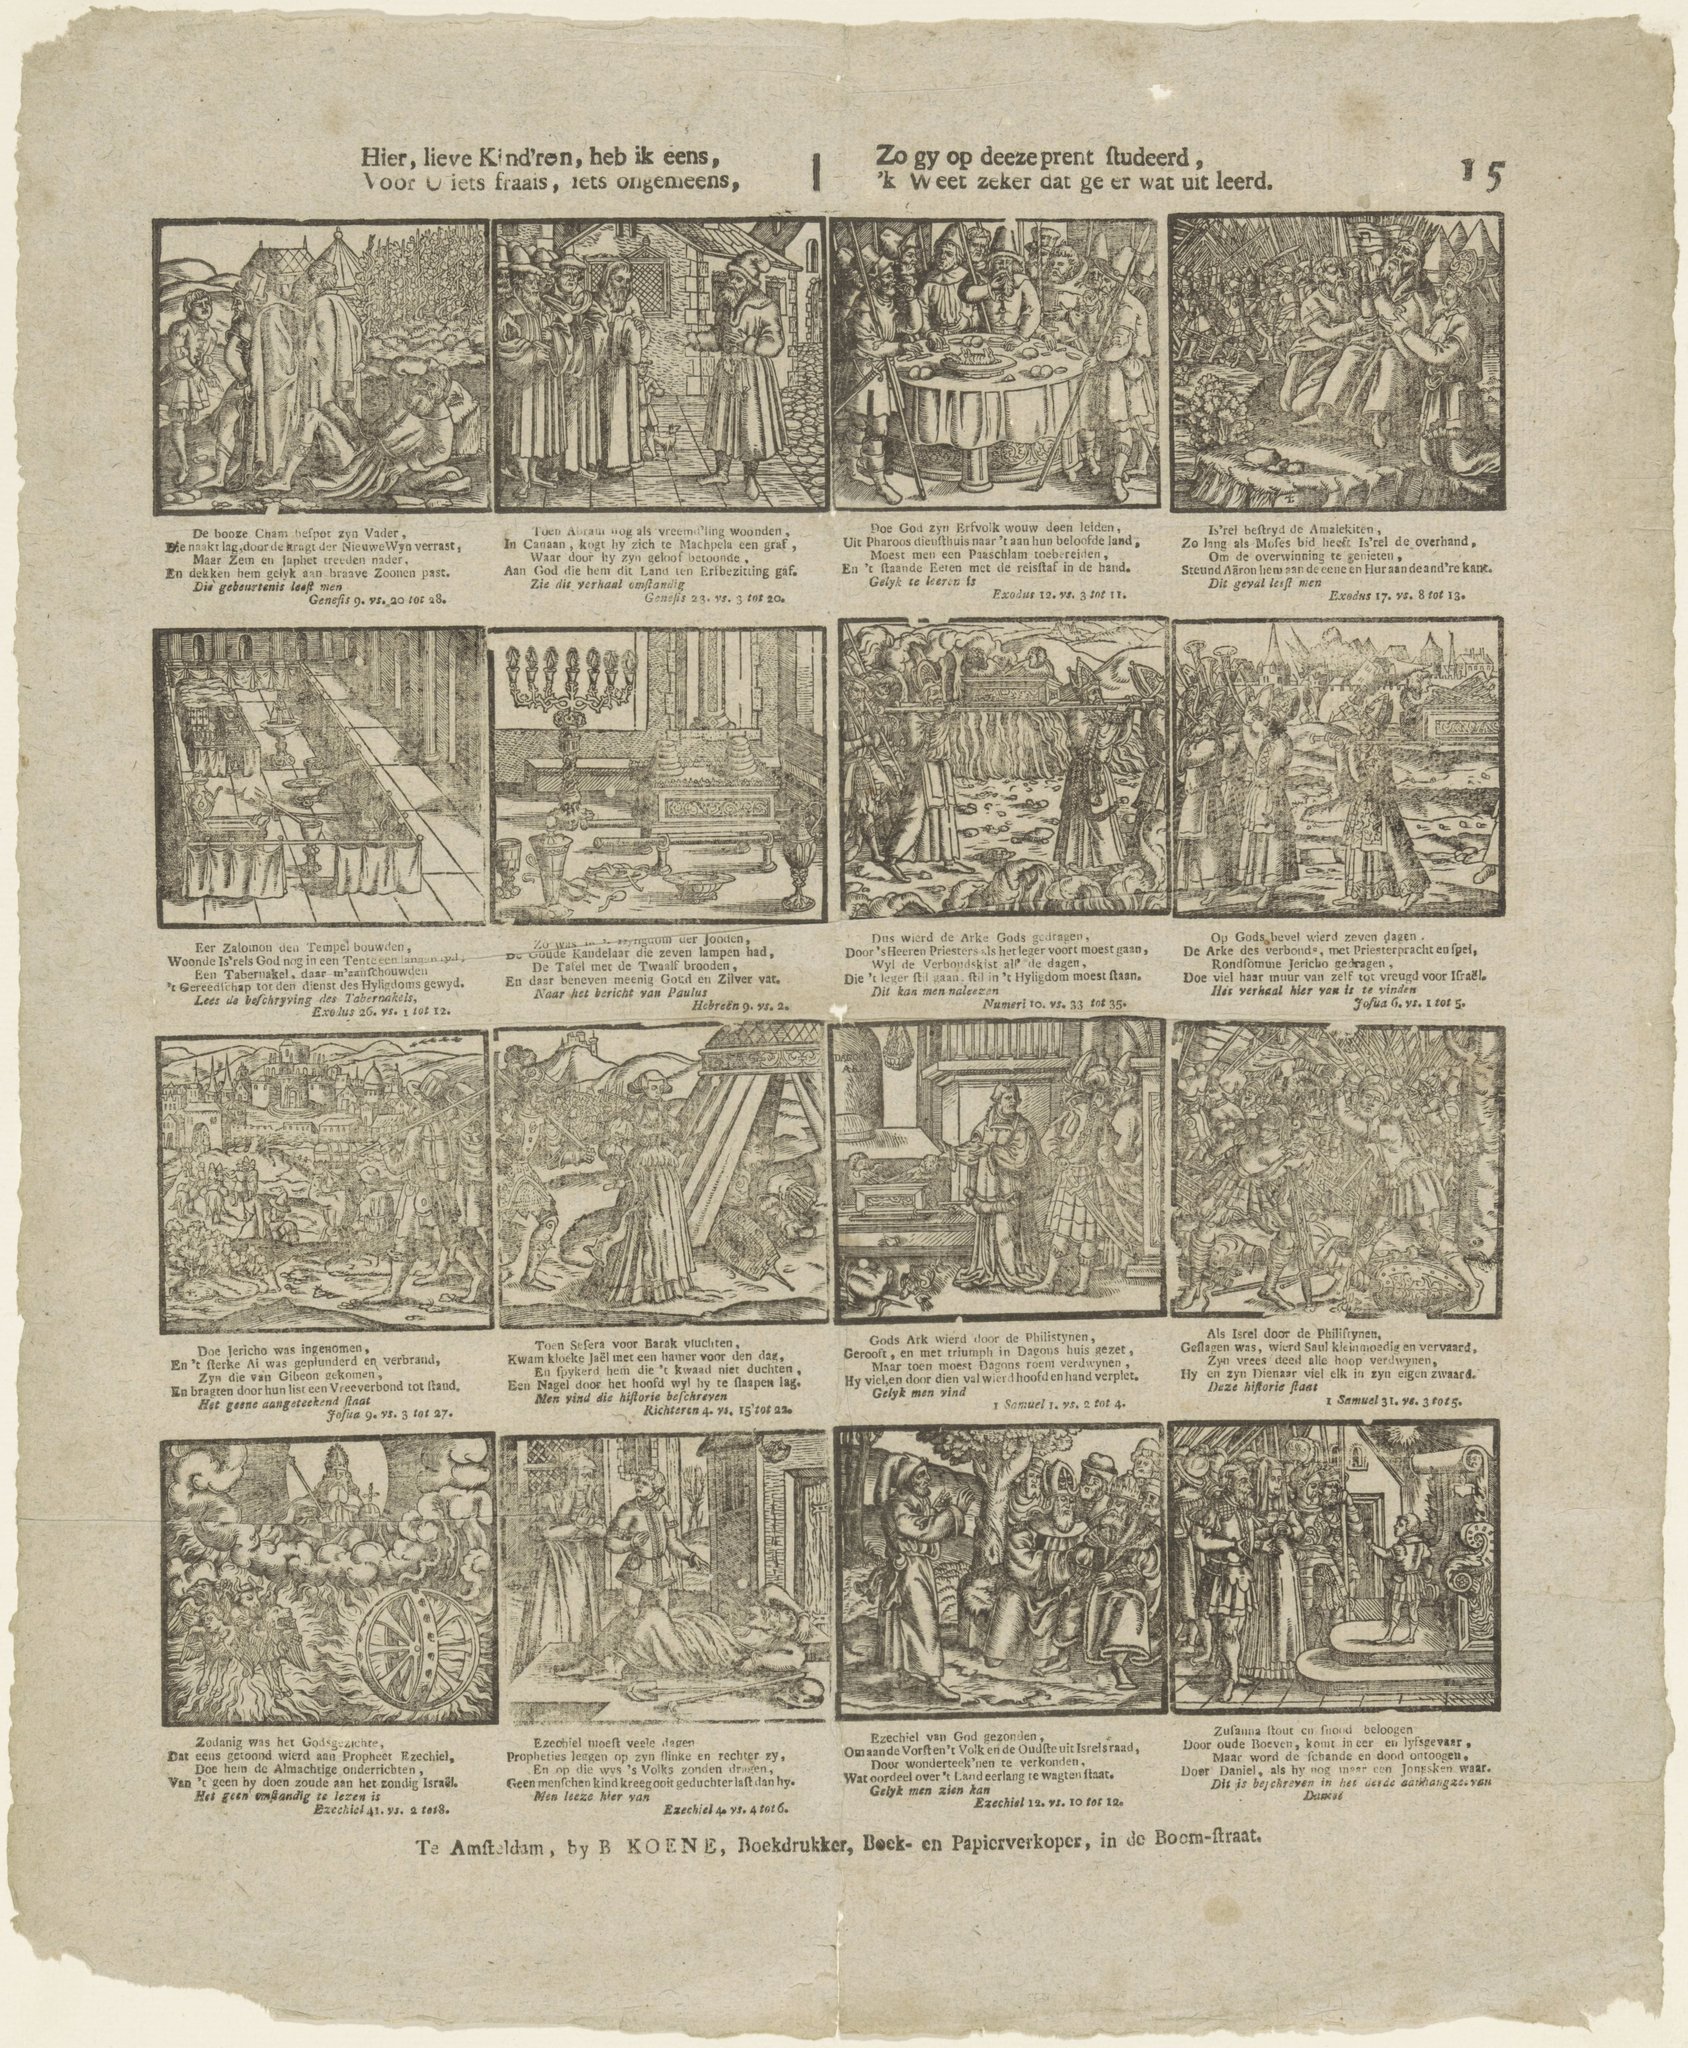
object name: print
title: Hier, lieve kind'ren, heb ik eens, / Voor u iets fraais, iets ongemeens, / Zo gy op deeze prent studeerd, / 'k weet zeker dat ge er wat uit leerd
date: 1814-1830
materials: paper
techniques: letterpress printing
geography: netherlands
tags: the ark of the covenant is carried by the levites, ezekiel's vision of god sitting on his throne carried by four tetramorphs, each of them having four wings; wheels within wheels beside them (+ variant), old testament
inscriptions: collector's mark: Lugt 2760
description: Blad met 16 voorstellingen uit het Oude Testament, waaronder mannen die de Ark des Verbonds dragen en het apocalyptische visioen van de profeet Ezechiël. Onder elke voorstelling een vierregelig vers en een verwijzing naar de bijbehorende Bijbeltekst. Genummerd rechtsboven: 15.